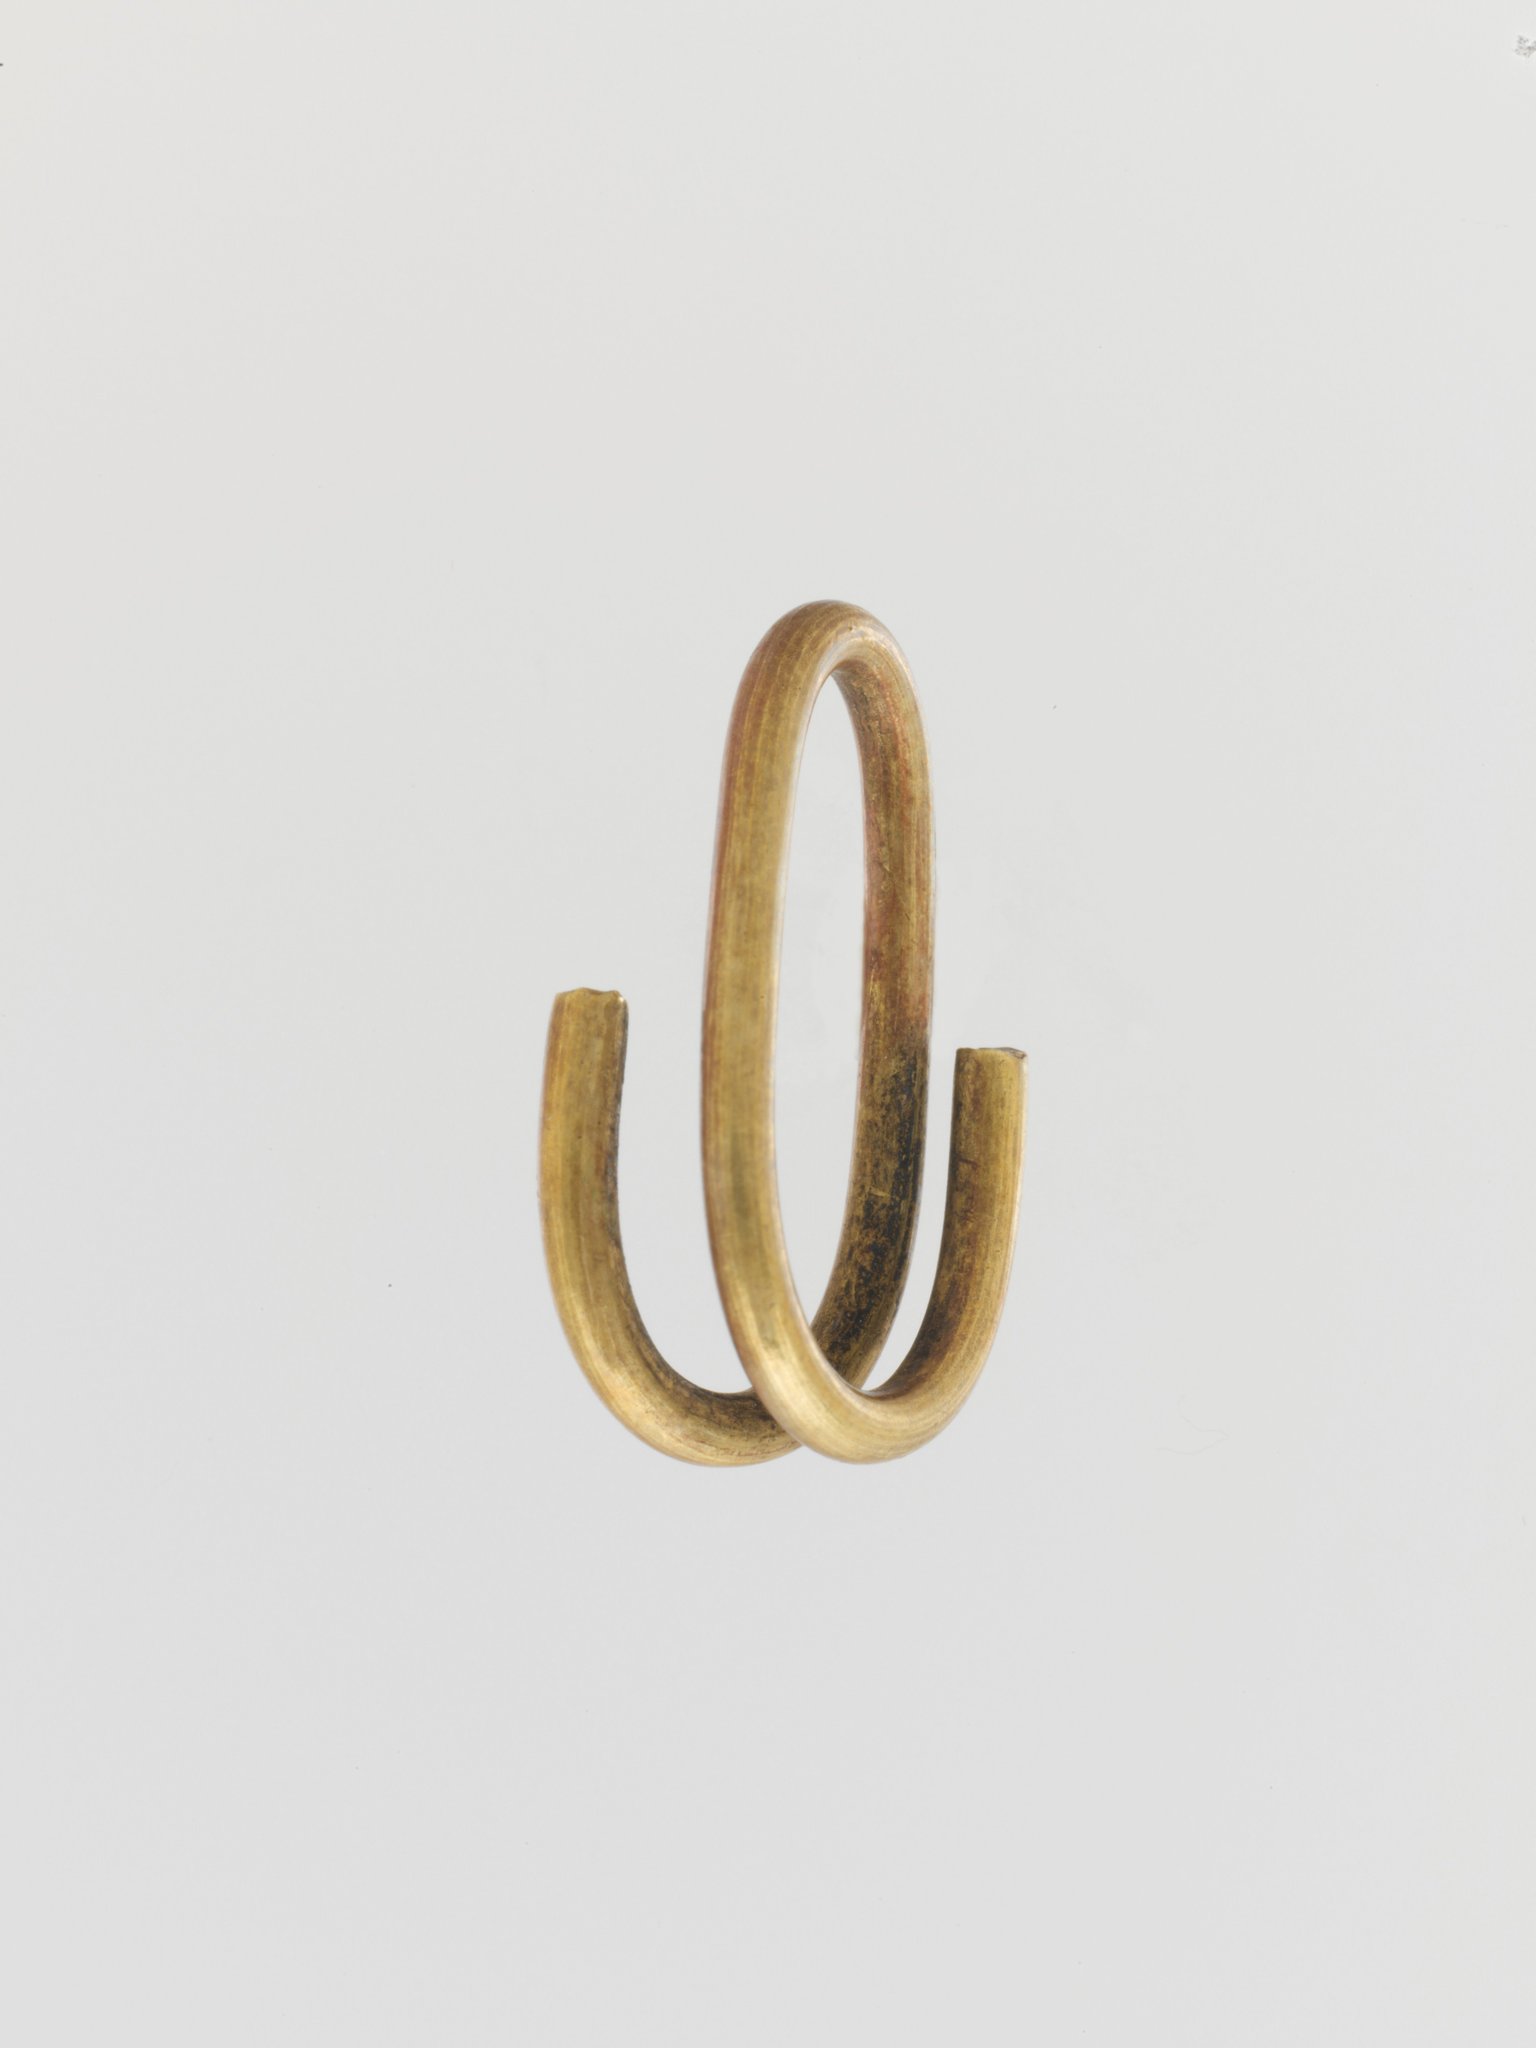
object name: earring or spiral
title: Gold spiral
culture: cypriot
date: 1600-1100 BCE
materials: gold